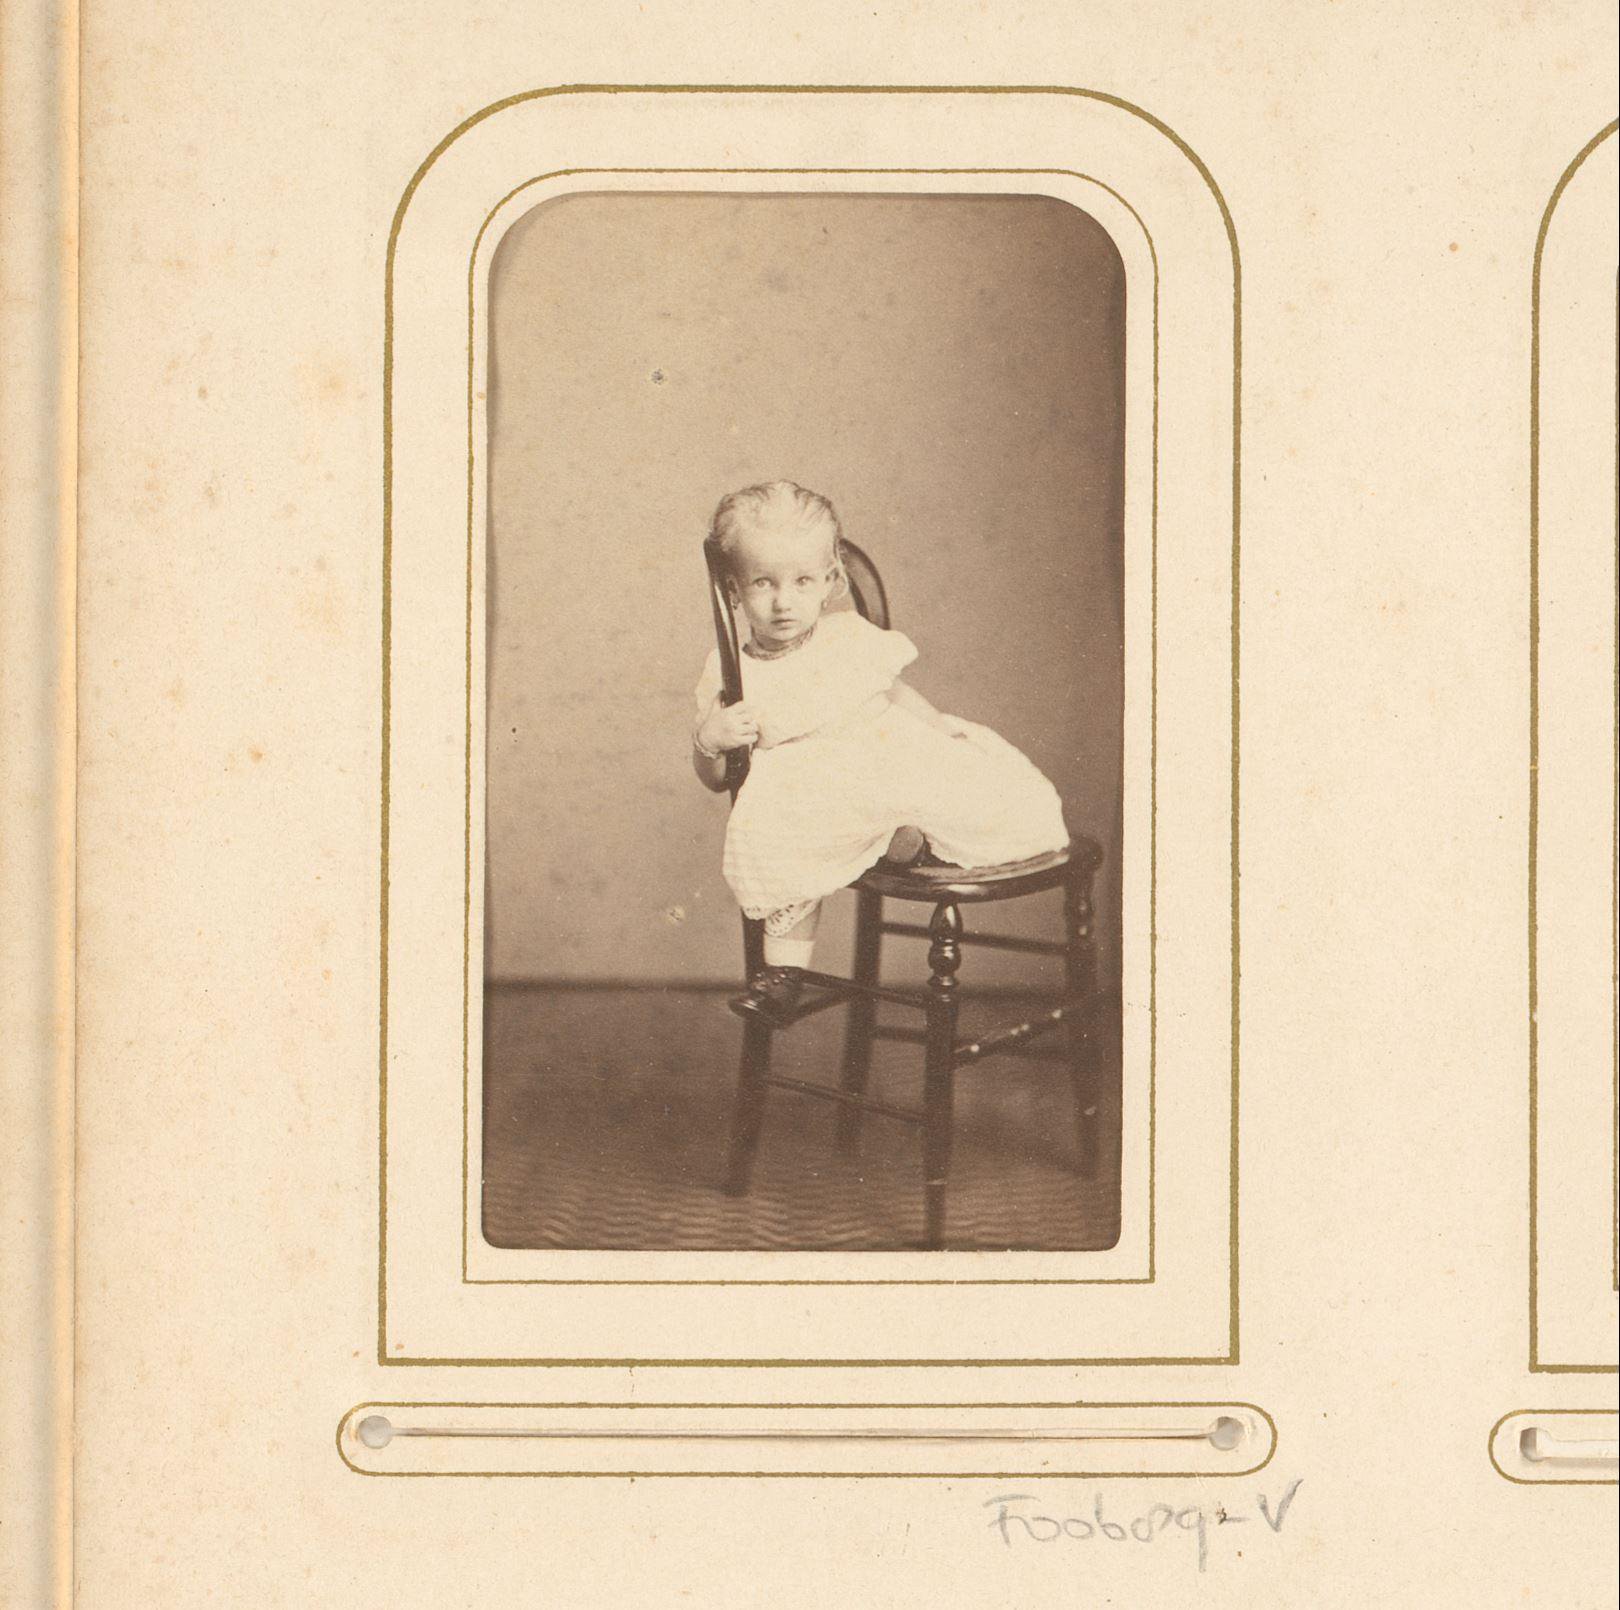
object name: album leaf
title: Portret van een kleuter in witte jurk, zittend op stoel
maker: james page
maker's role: fotograaf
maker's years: 1833-1865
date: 1857-1865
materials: cardboard, photographic support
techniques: albumen print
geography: java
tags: girl (child between toddler and youth)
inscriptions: inscription: ‘Page/ Photographer/ Java’